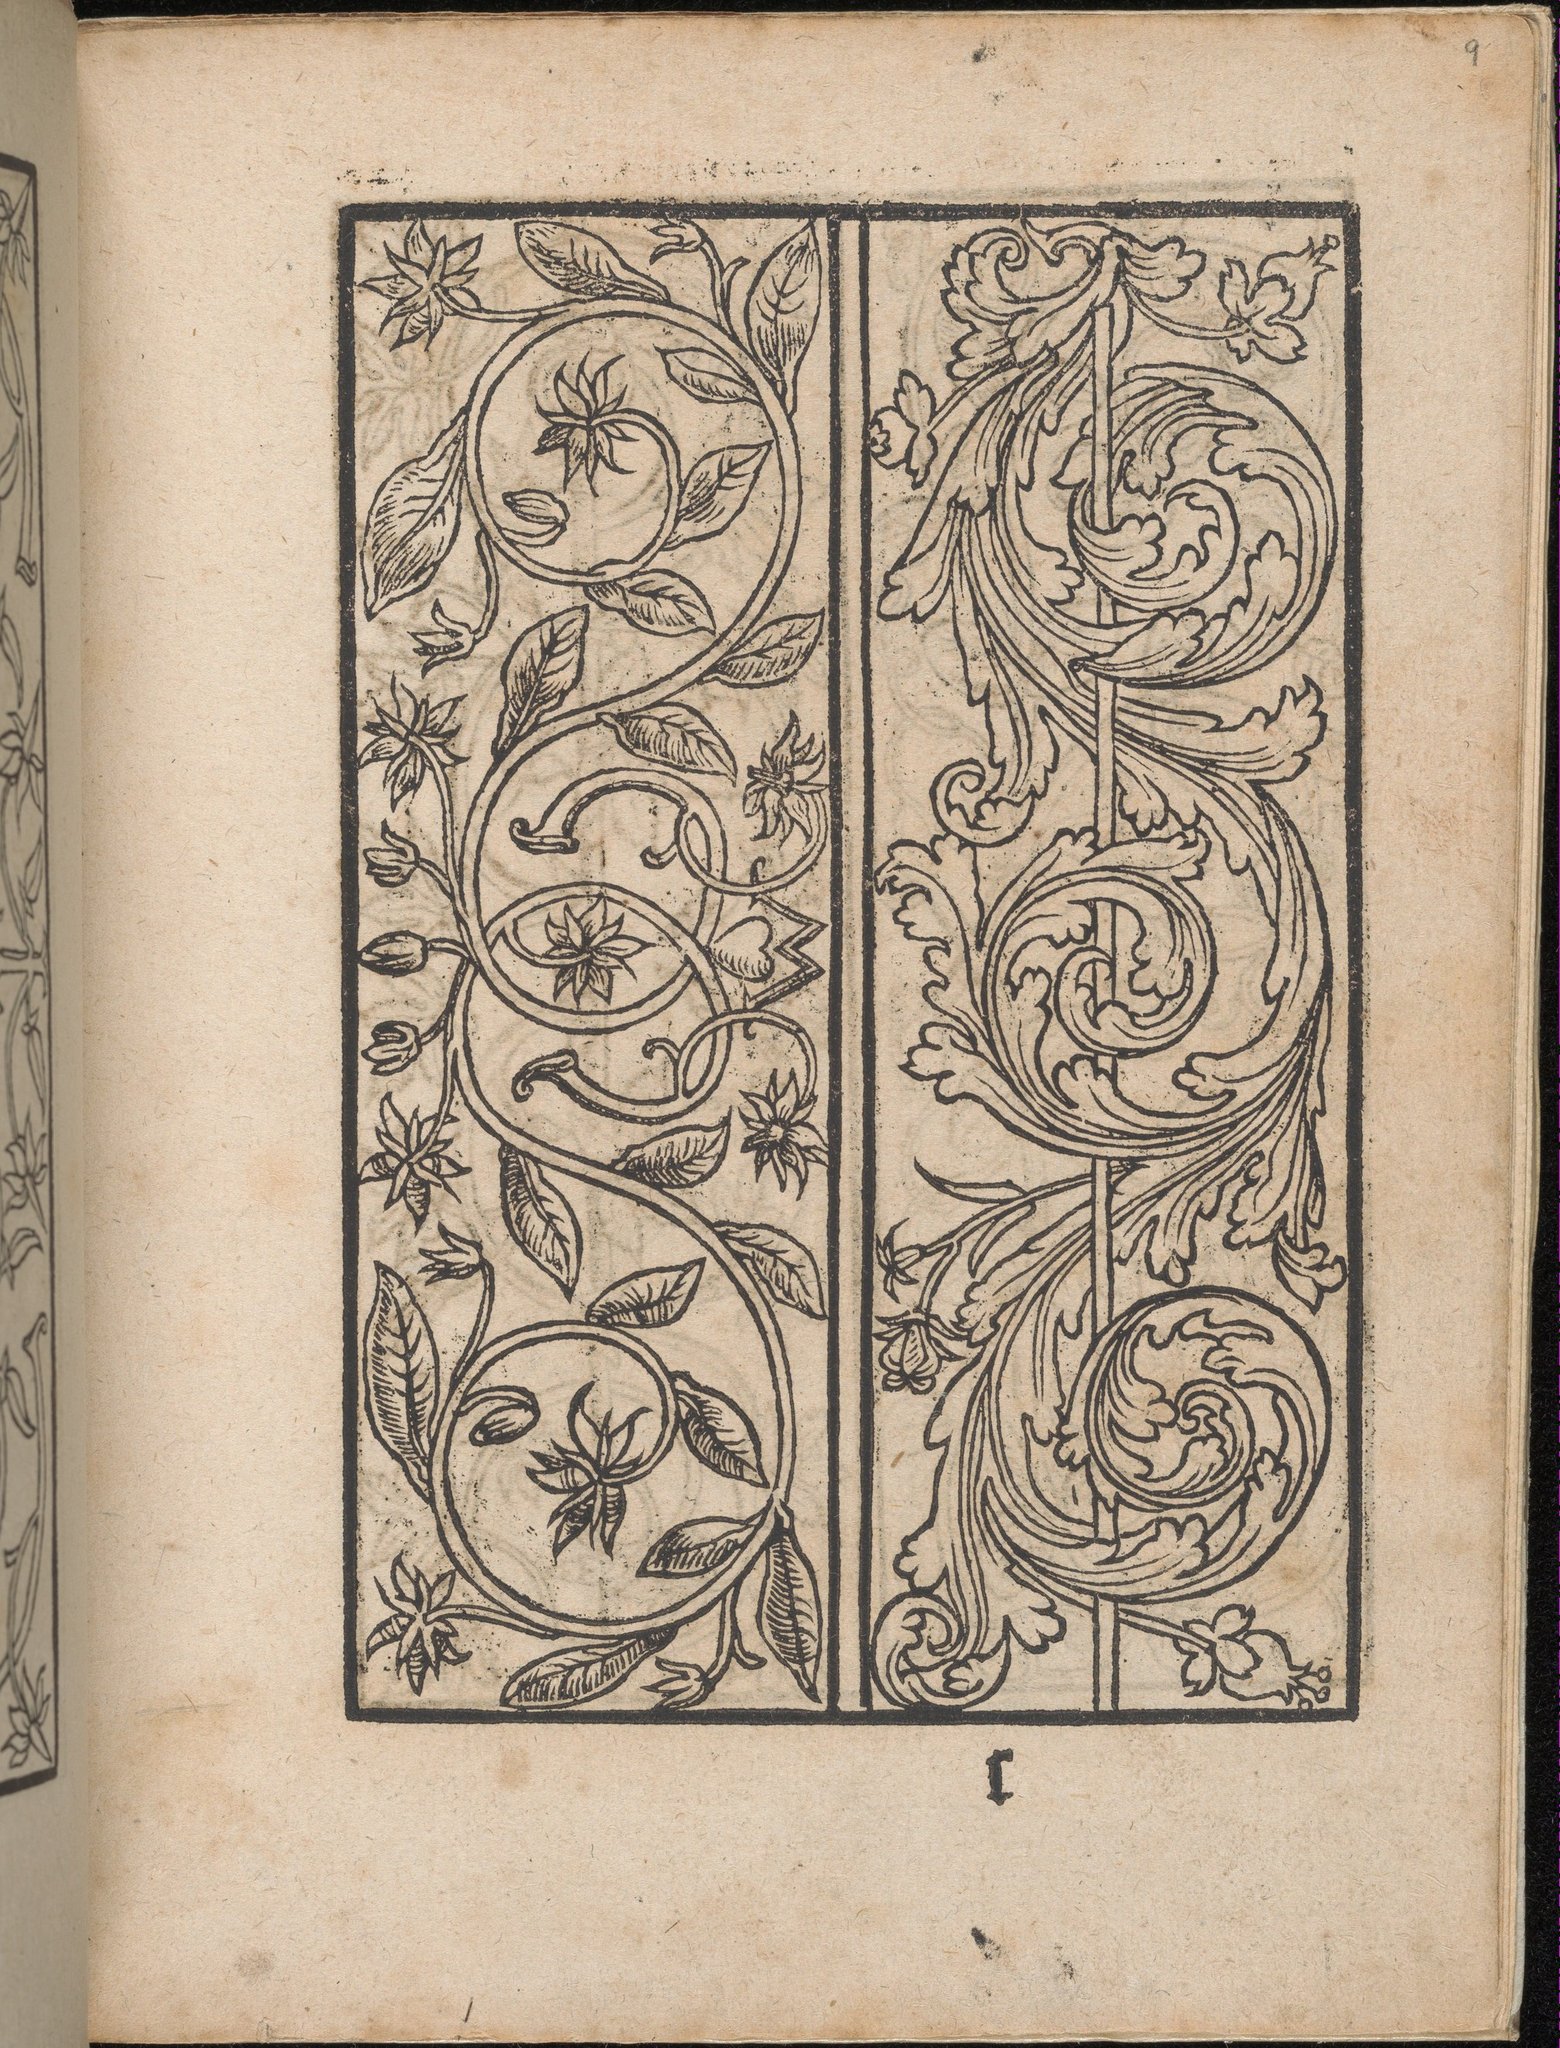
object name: book print ornament architecture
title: Ein new Modelbuch..., page 9 (recto)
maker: johann schönsperger the younger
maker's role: publisher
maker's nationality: german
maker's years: 1490-1550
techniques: woodcut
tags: ornament